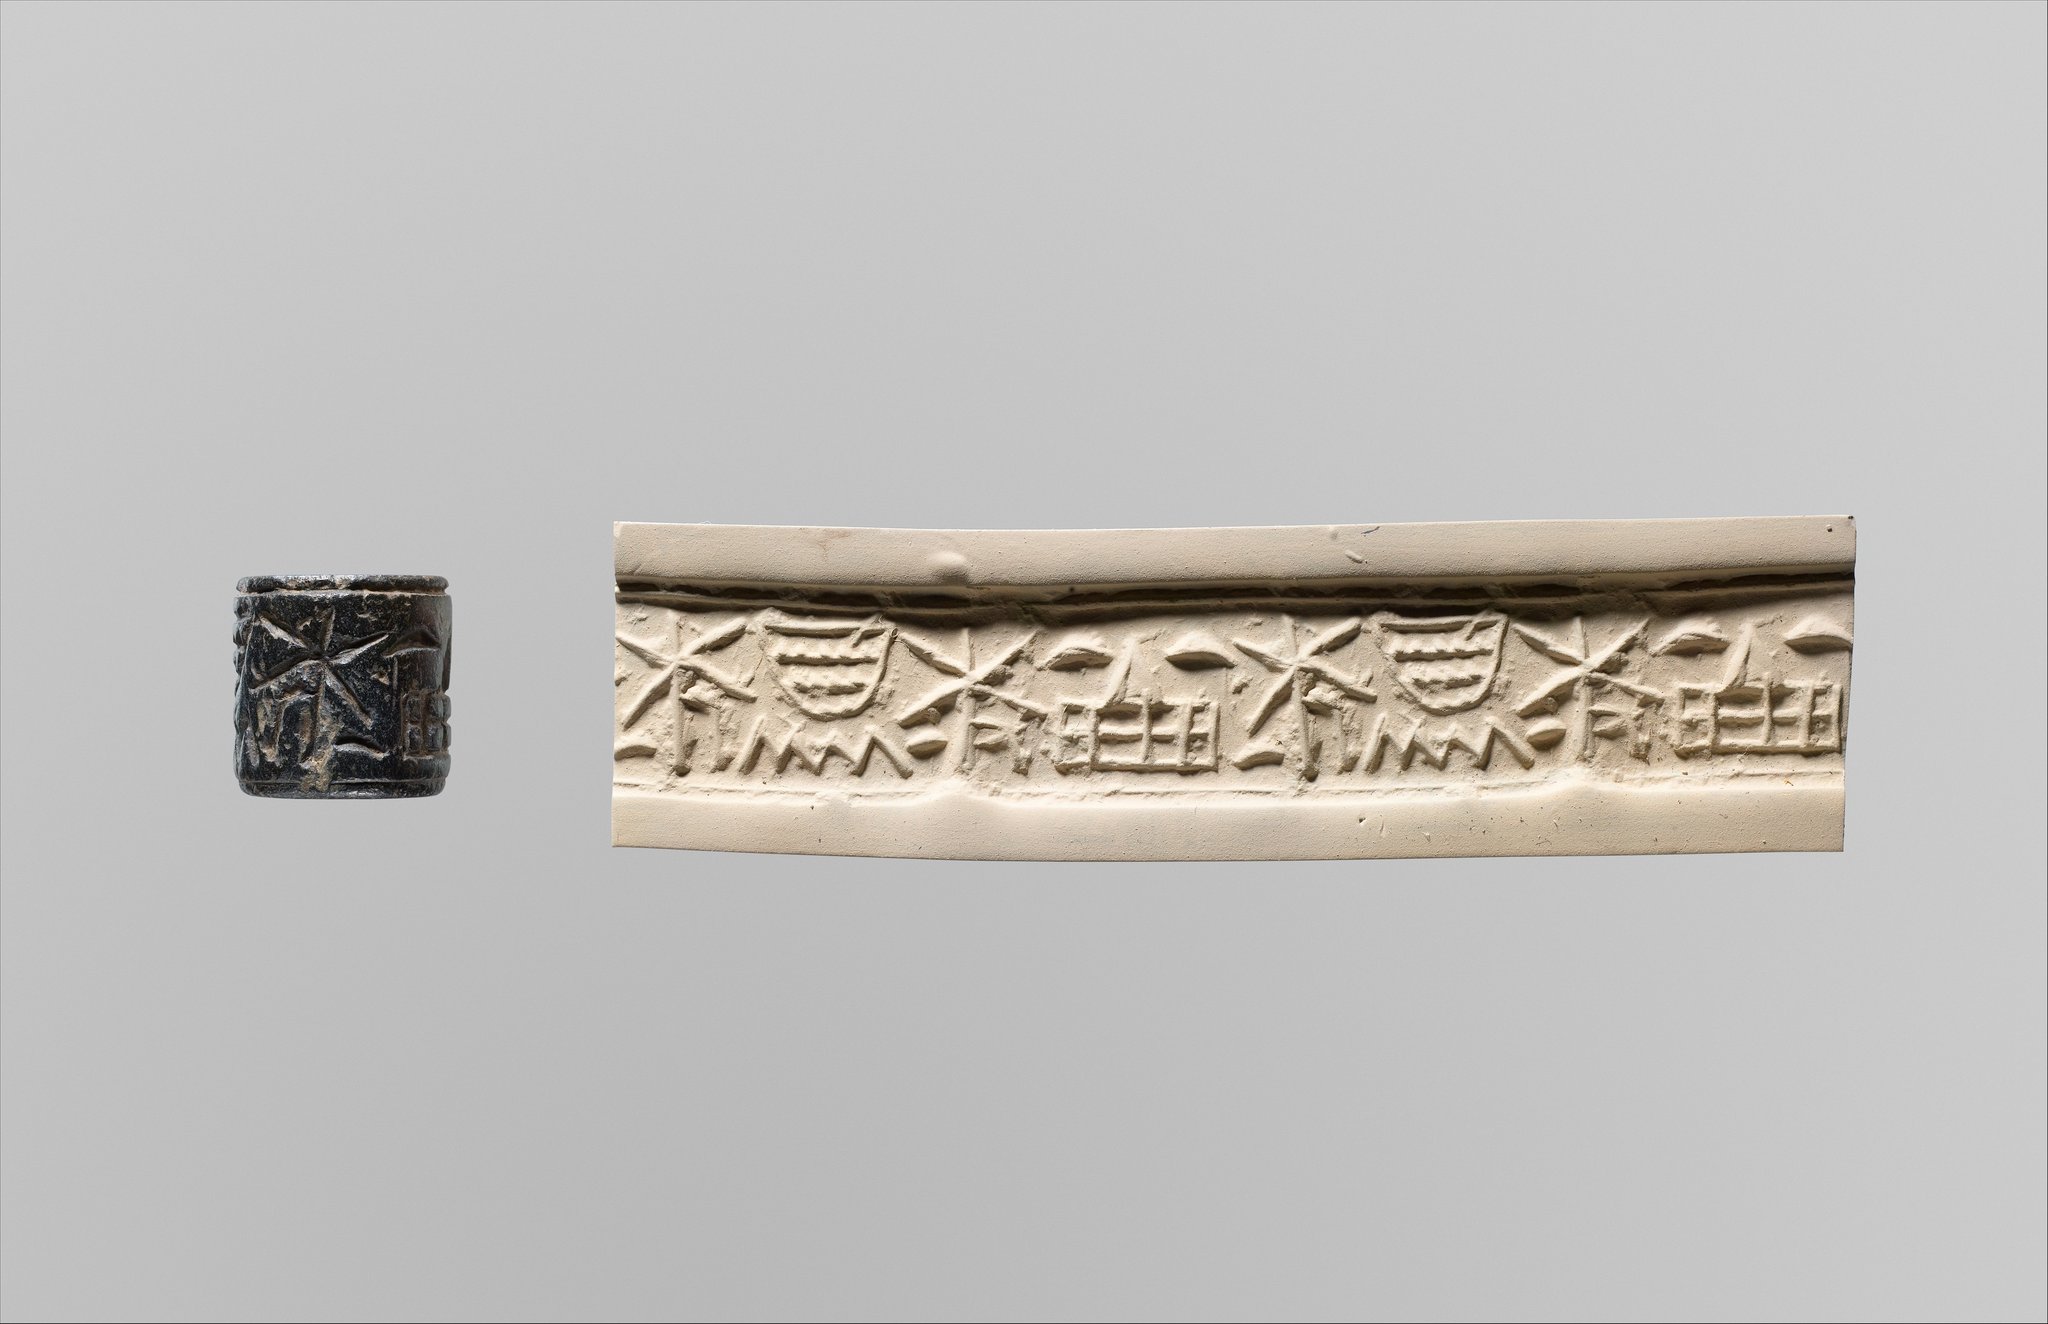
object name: cylinder seal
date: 3100-2650 BCE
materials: stone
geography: egypt